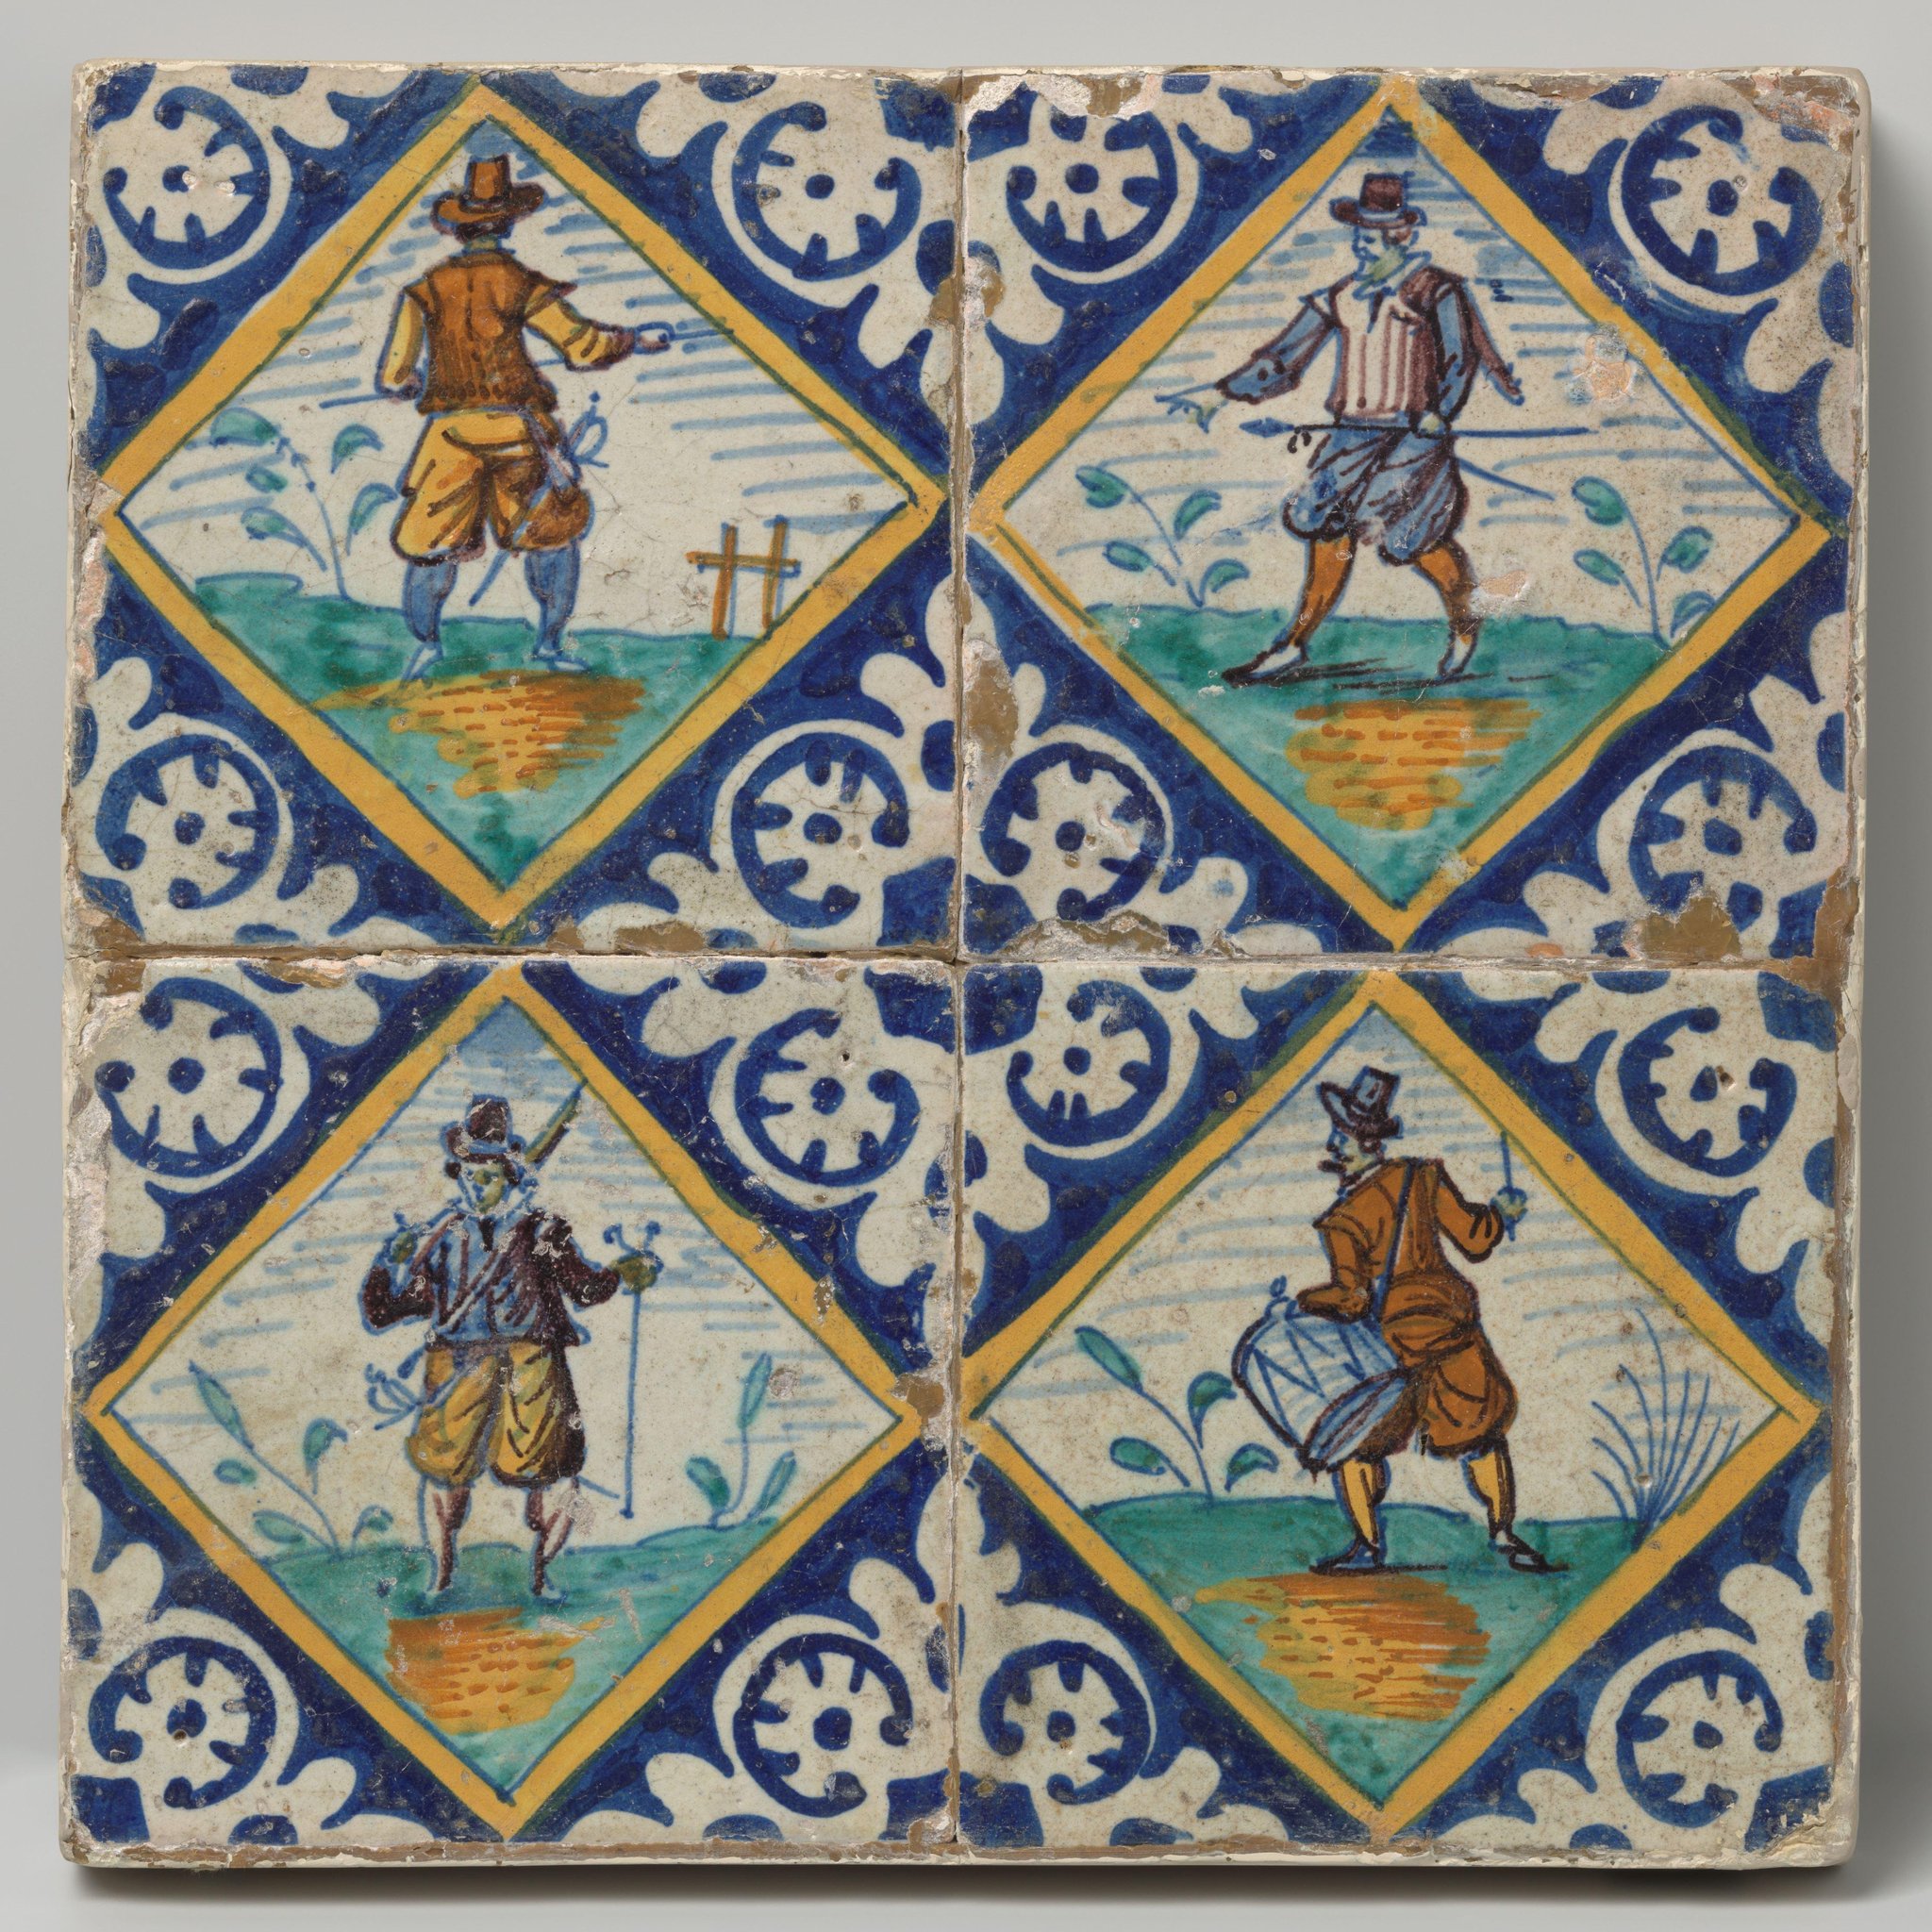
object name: tegelveld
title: Veld van vier tegels met jagers en dieren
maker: Anonymous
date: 1580-1625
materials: earthenware, glaze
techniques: maiolica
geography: netherlands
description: Veld van vier tegels (2 x 2) elk met een veelkleurige (blauw, oranje, geel, groen en paars) jager op een grondje binnen een kwadraat. In de hoeken, ornament in vultechniek.